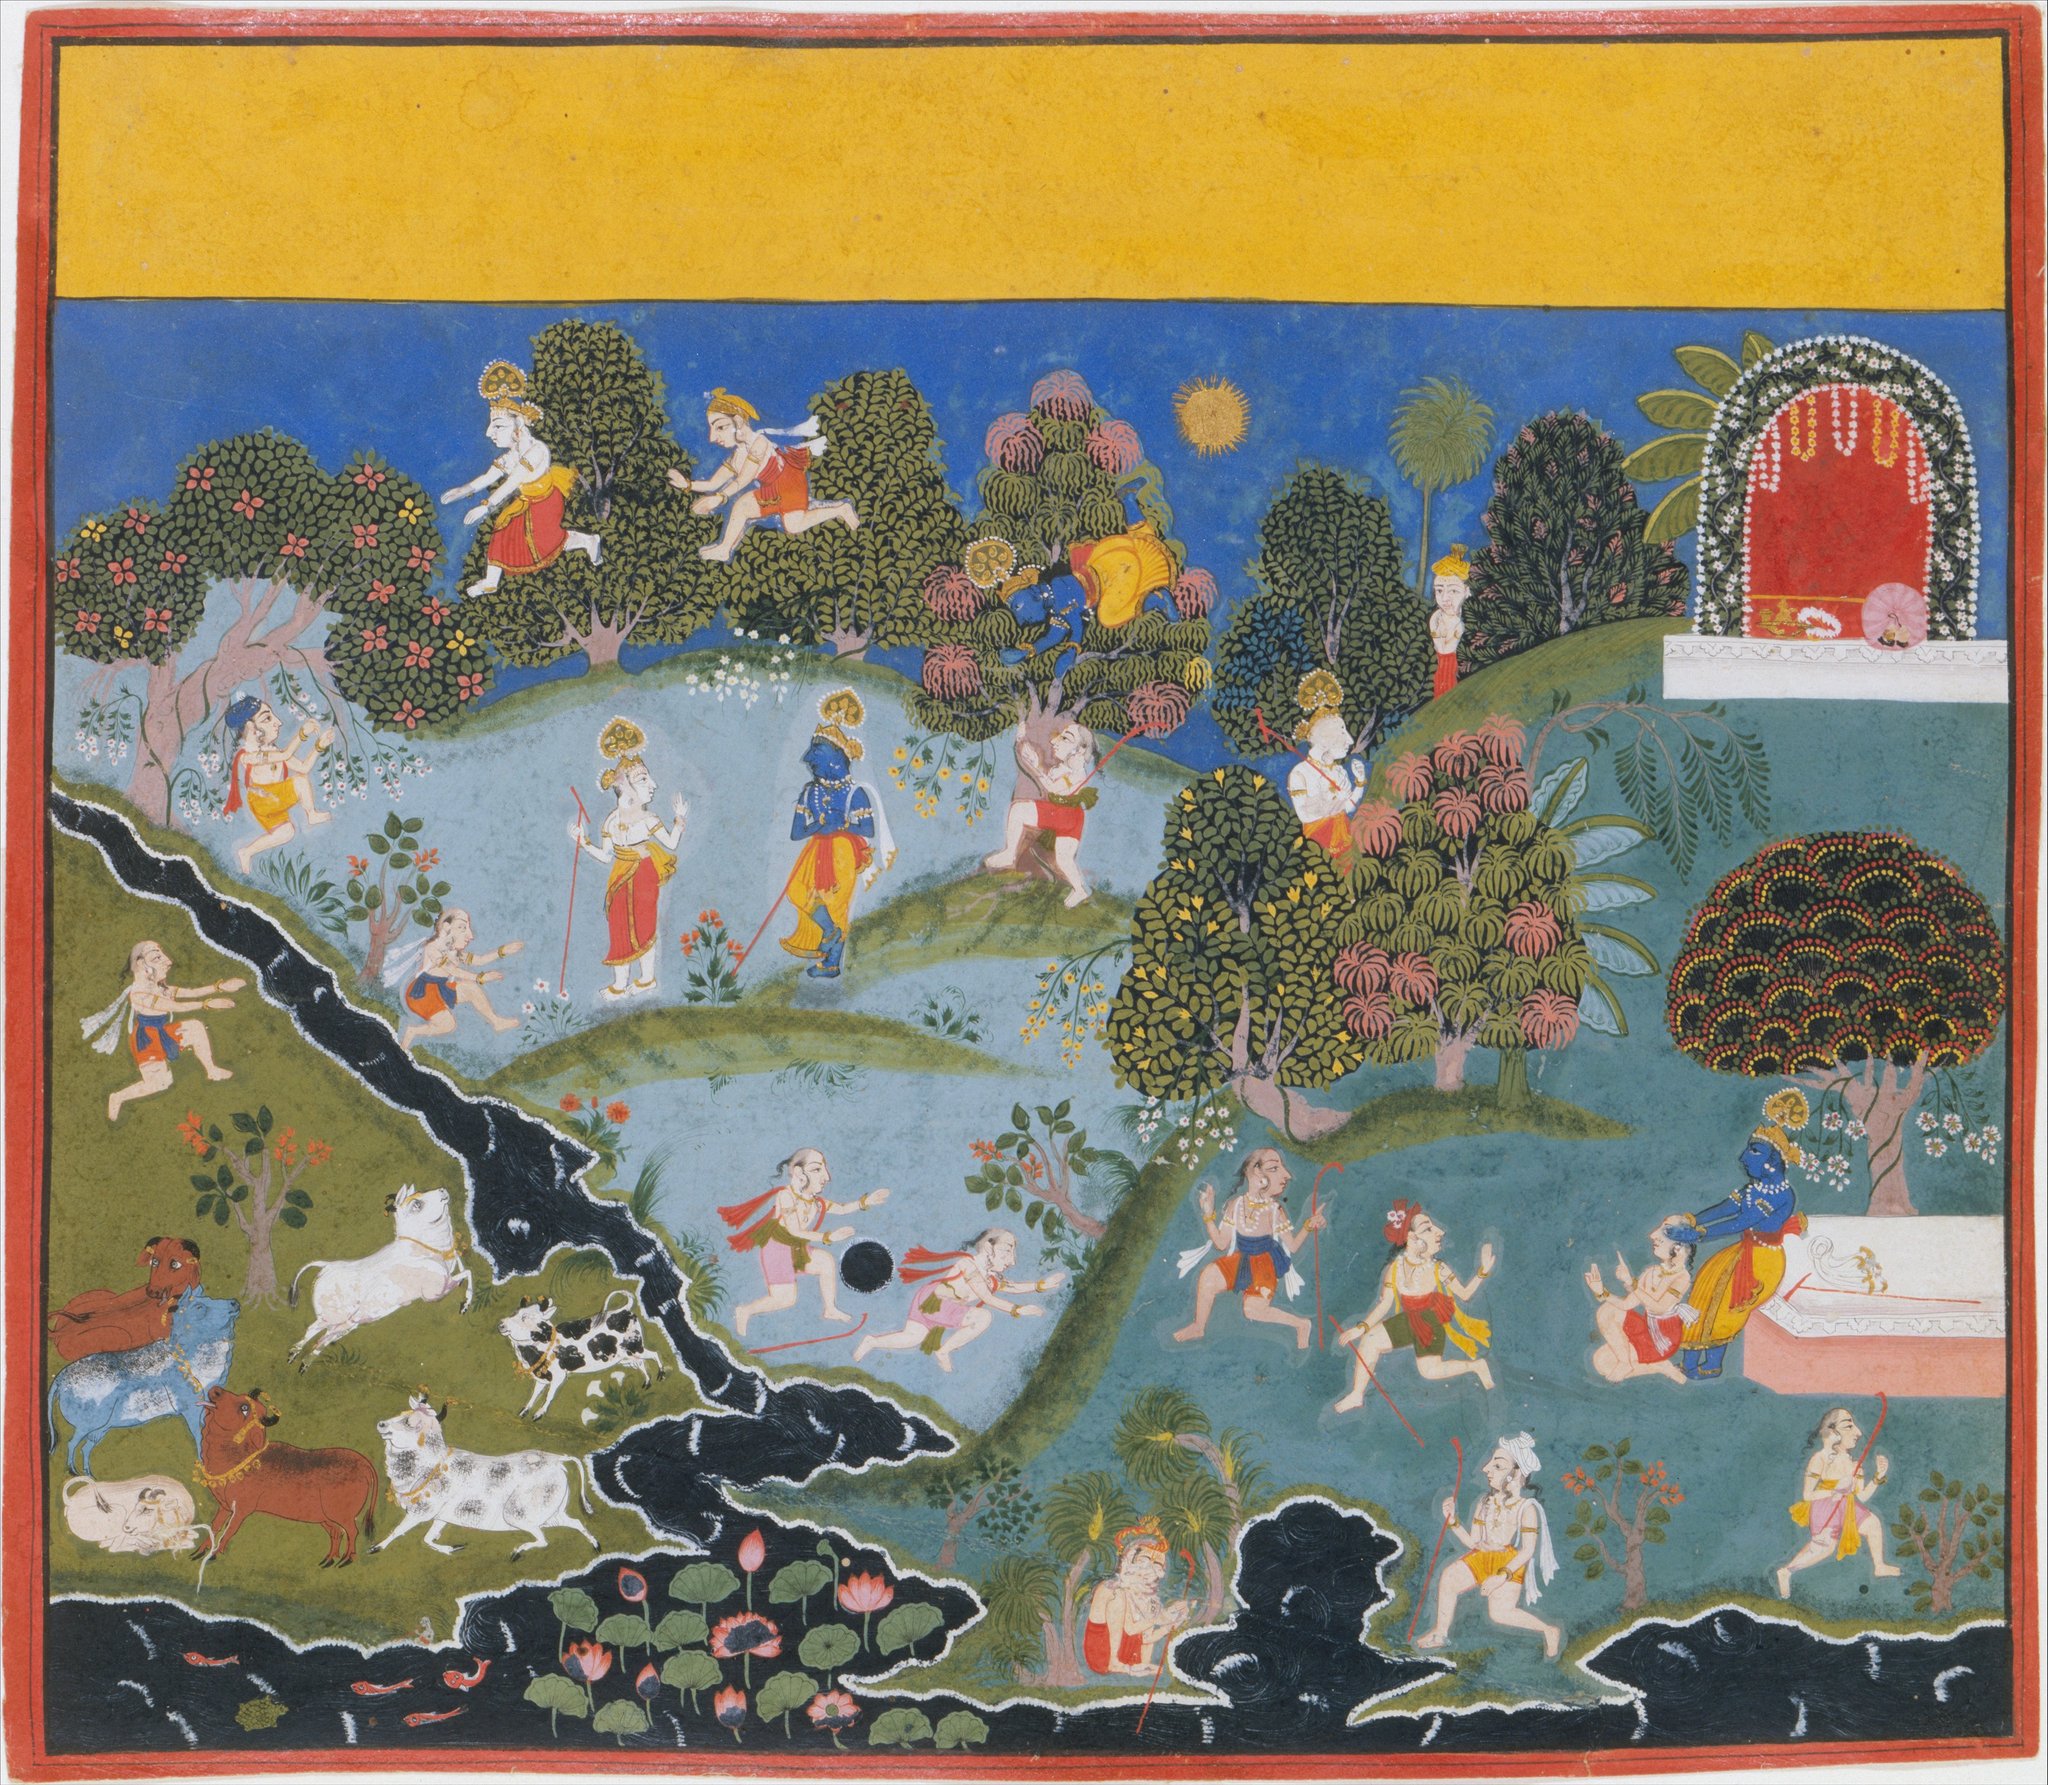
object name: folio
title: Blindman's Bluff: Page From a Dispersed Bhagavata Purana (Ancient Stories of Lord Vishnu)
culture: mewar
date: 1715-1720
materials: gold, ink, paper, watercolor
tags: men,cows,landscapes,krishna,games